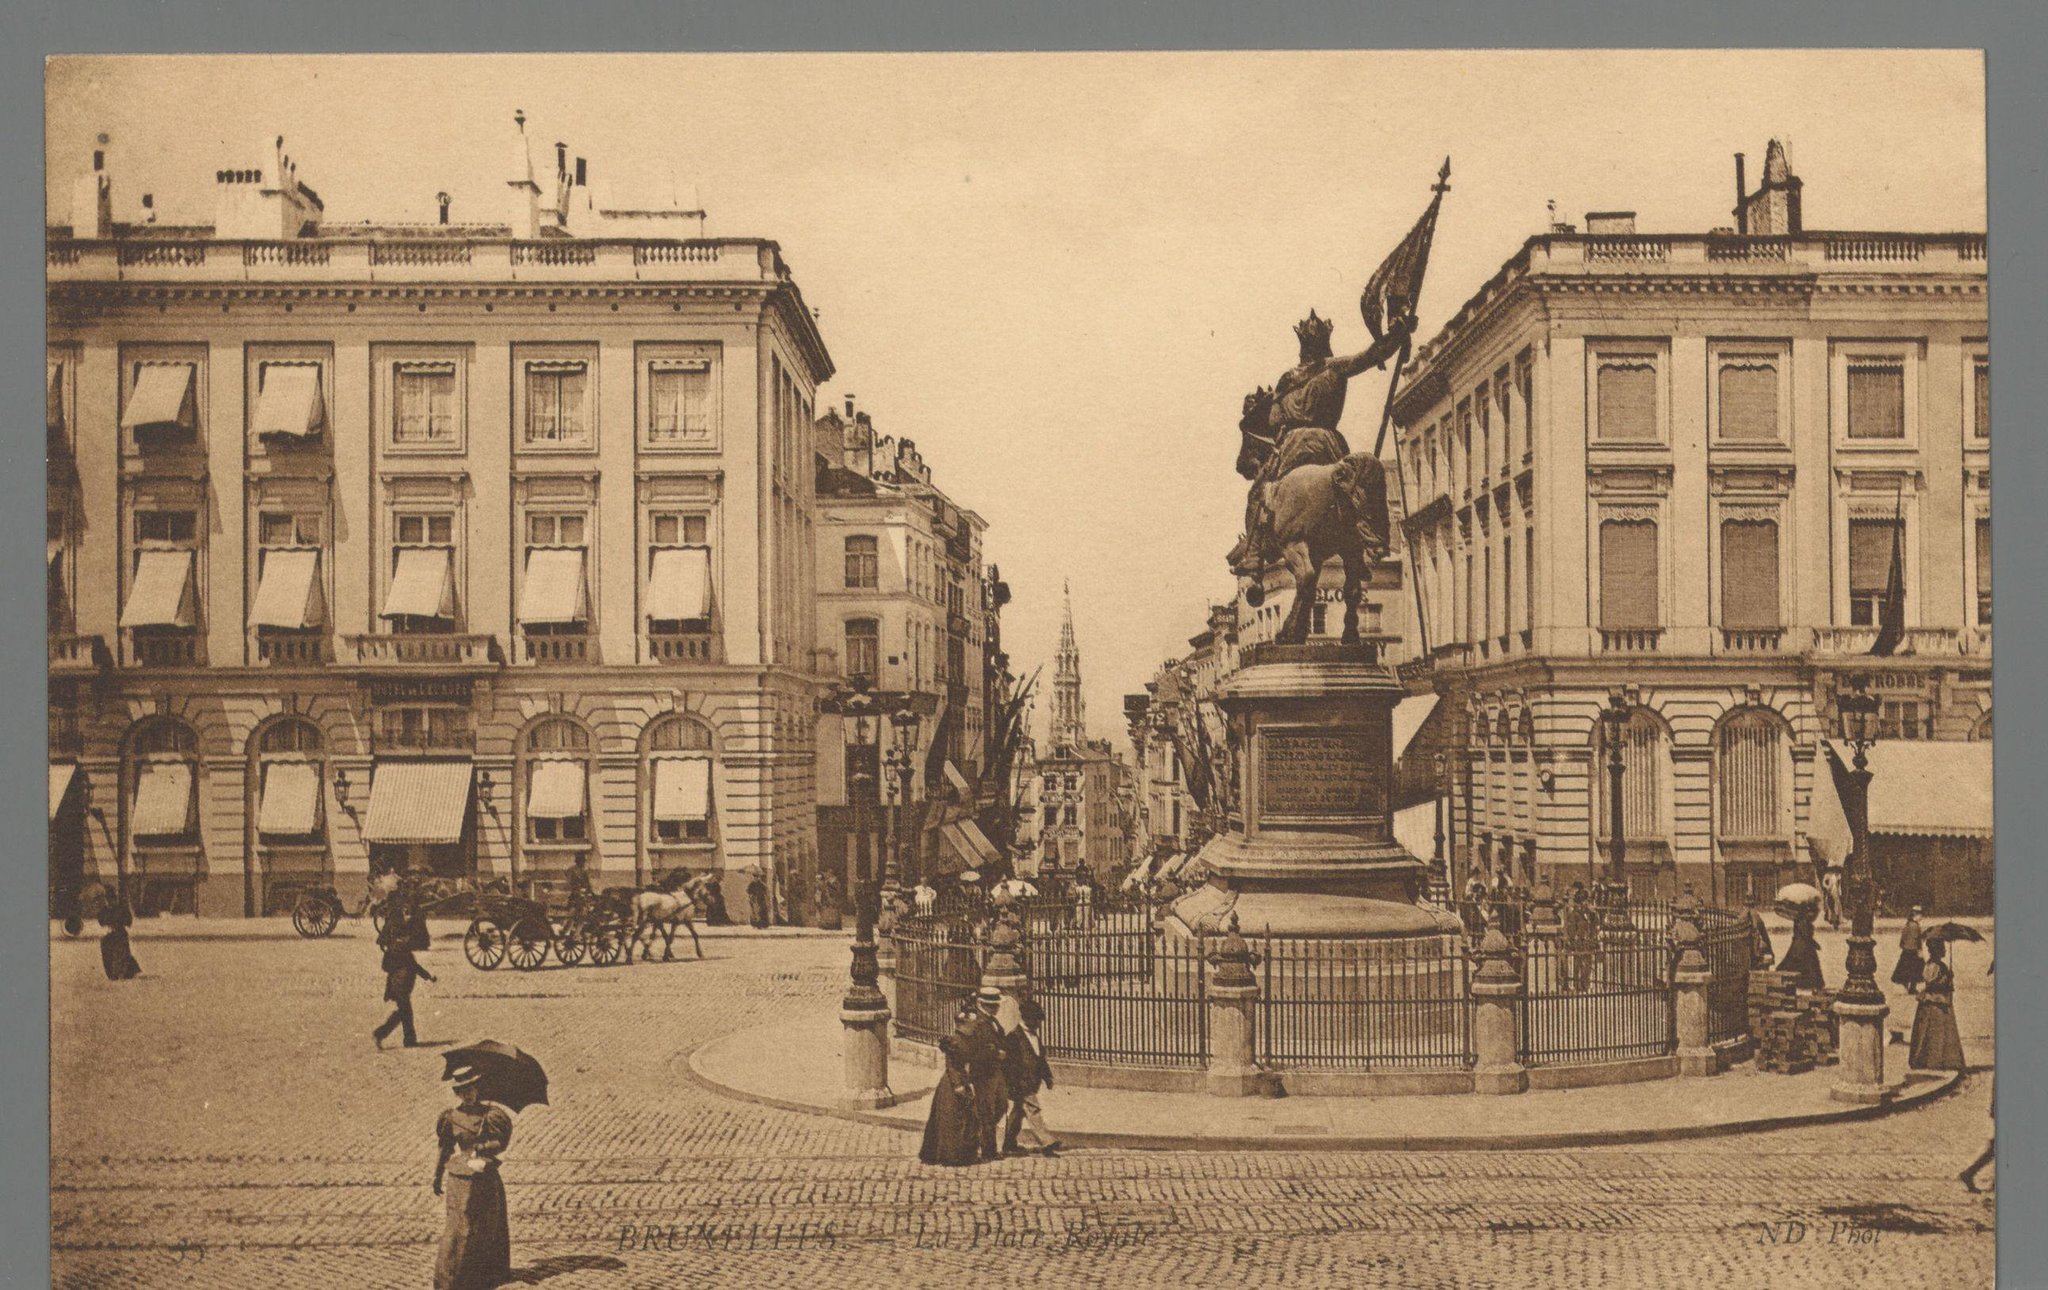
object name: ansichtkaart, prentbriefkaart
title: Bruxelles. La Place Royale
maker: Anonymous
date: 1906-1918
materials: cardboard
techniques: photograph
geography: brussels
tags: monument, statue, square, place, circus, etc. (+ city(-scape) with figures, staffage)